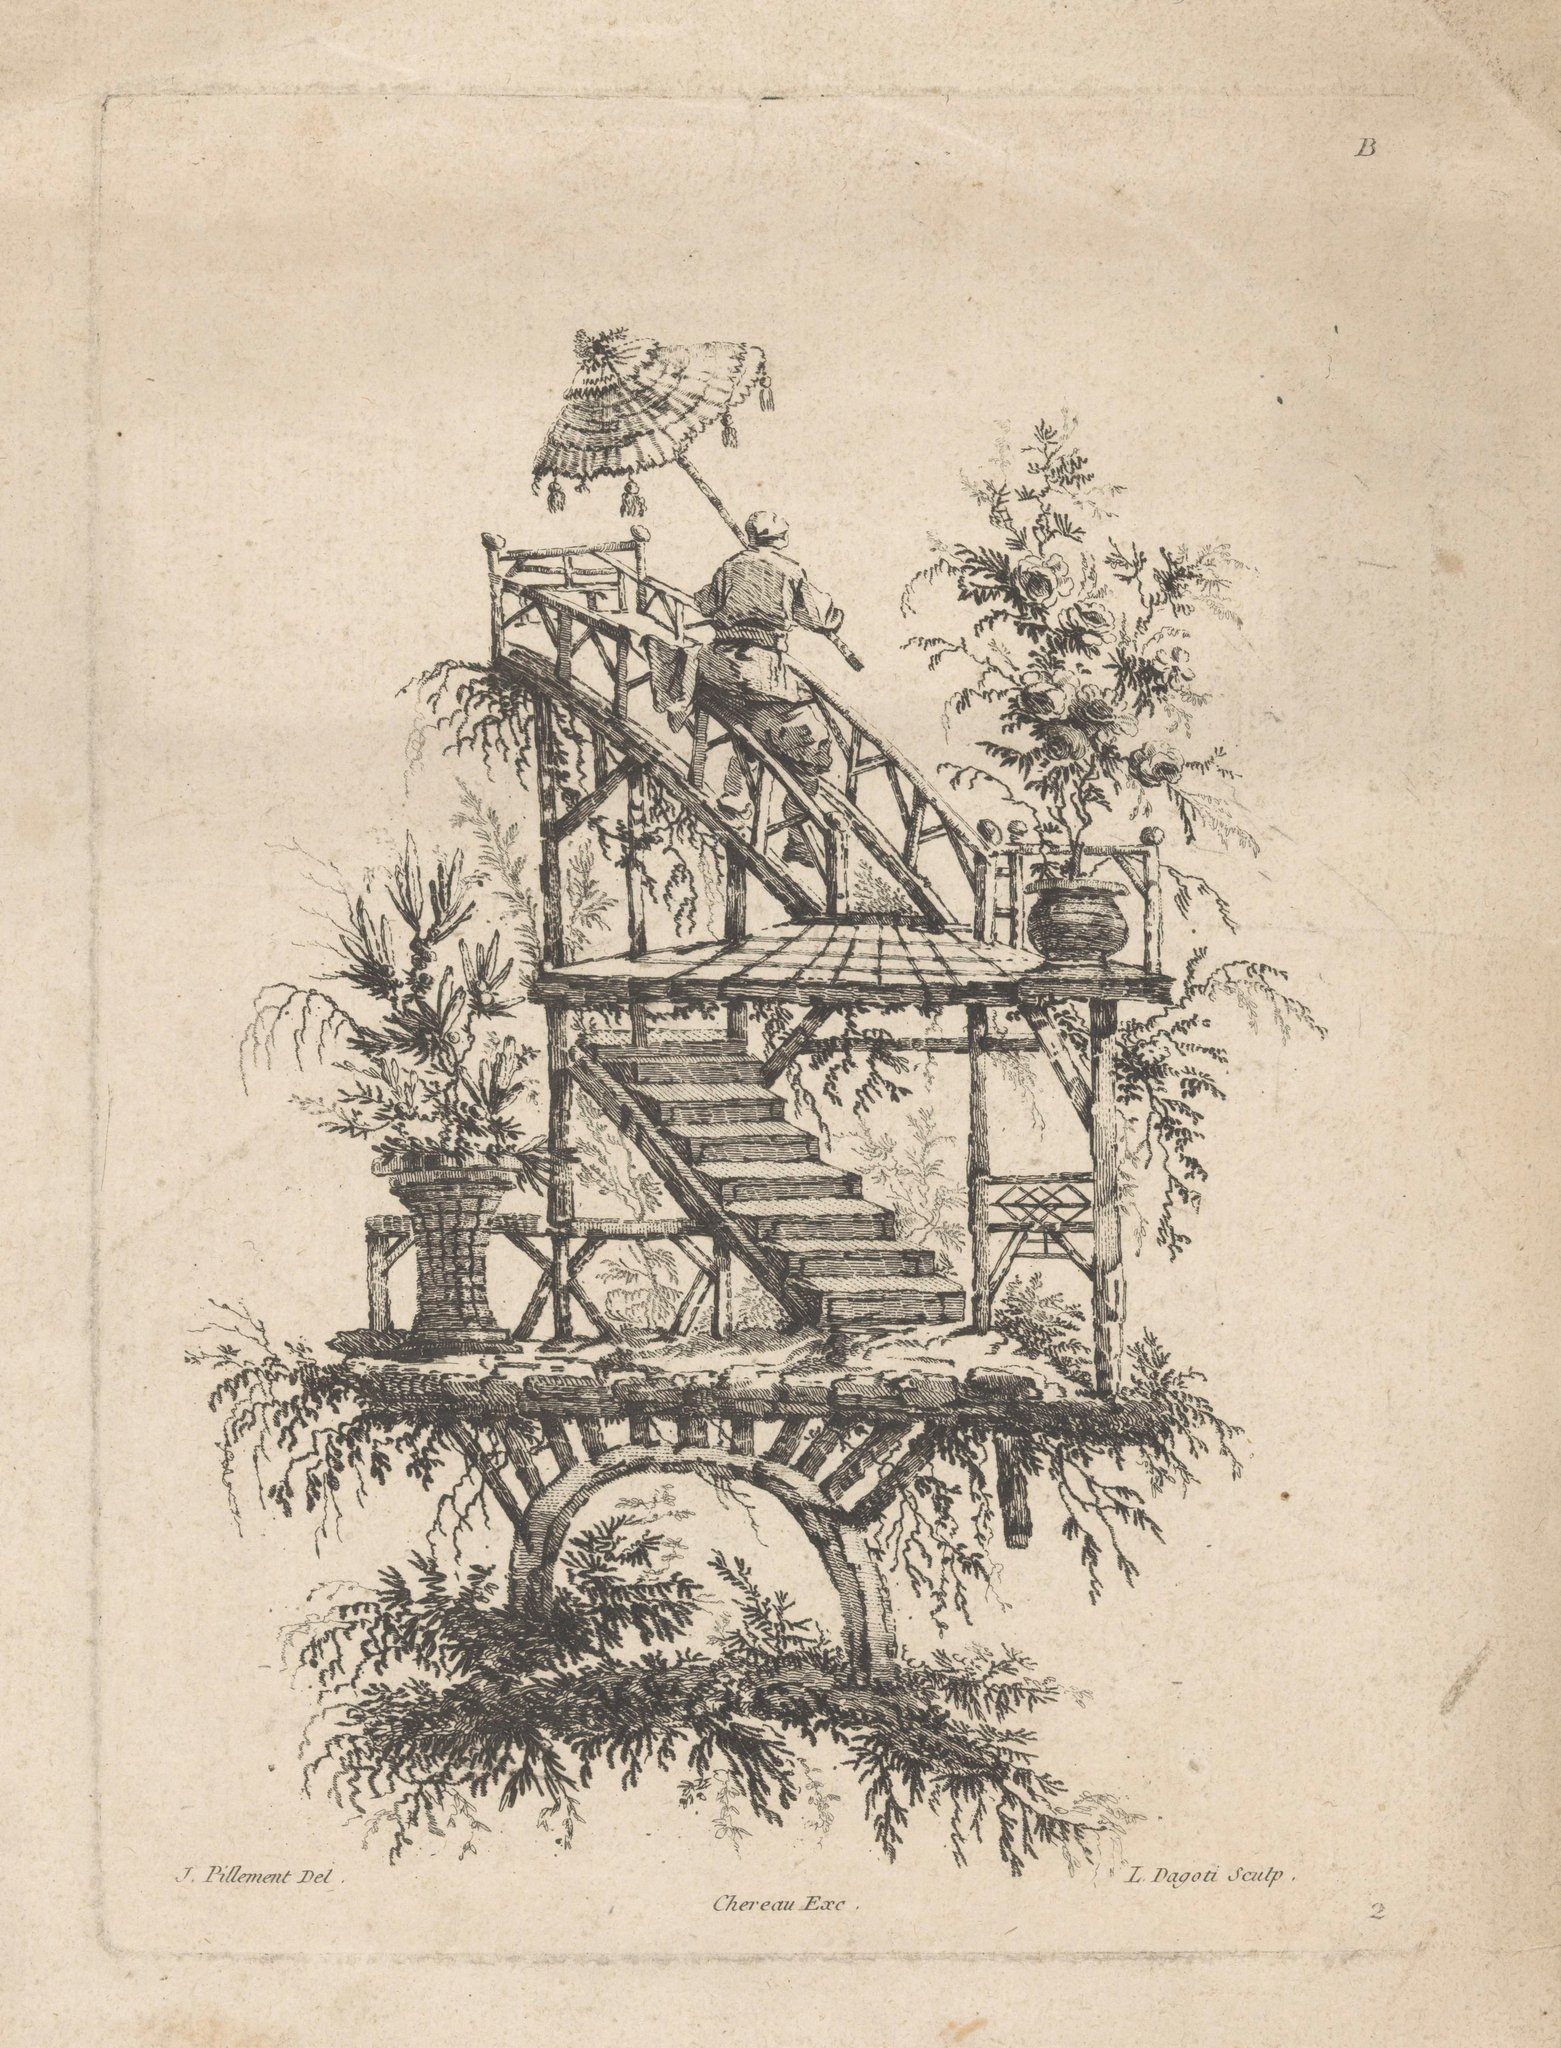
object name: ornament print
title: Man met parasol op trap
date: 1756-1787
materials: paper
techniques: etching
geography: paris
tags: sitting figure, staircase, parasol, sunshade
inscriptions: collector's mark: Lugt 2228, collector's mark: Lugt 2760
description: In een landschap zit een man met een parasol op de leuning van een trap. Links en rechts op de trap staan vazen met planten en bloemen. Rechts boven B genummerd.